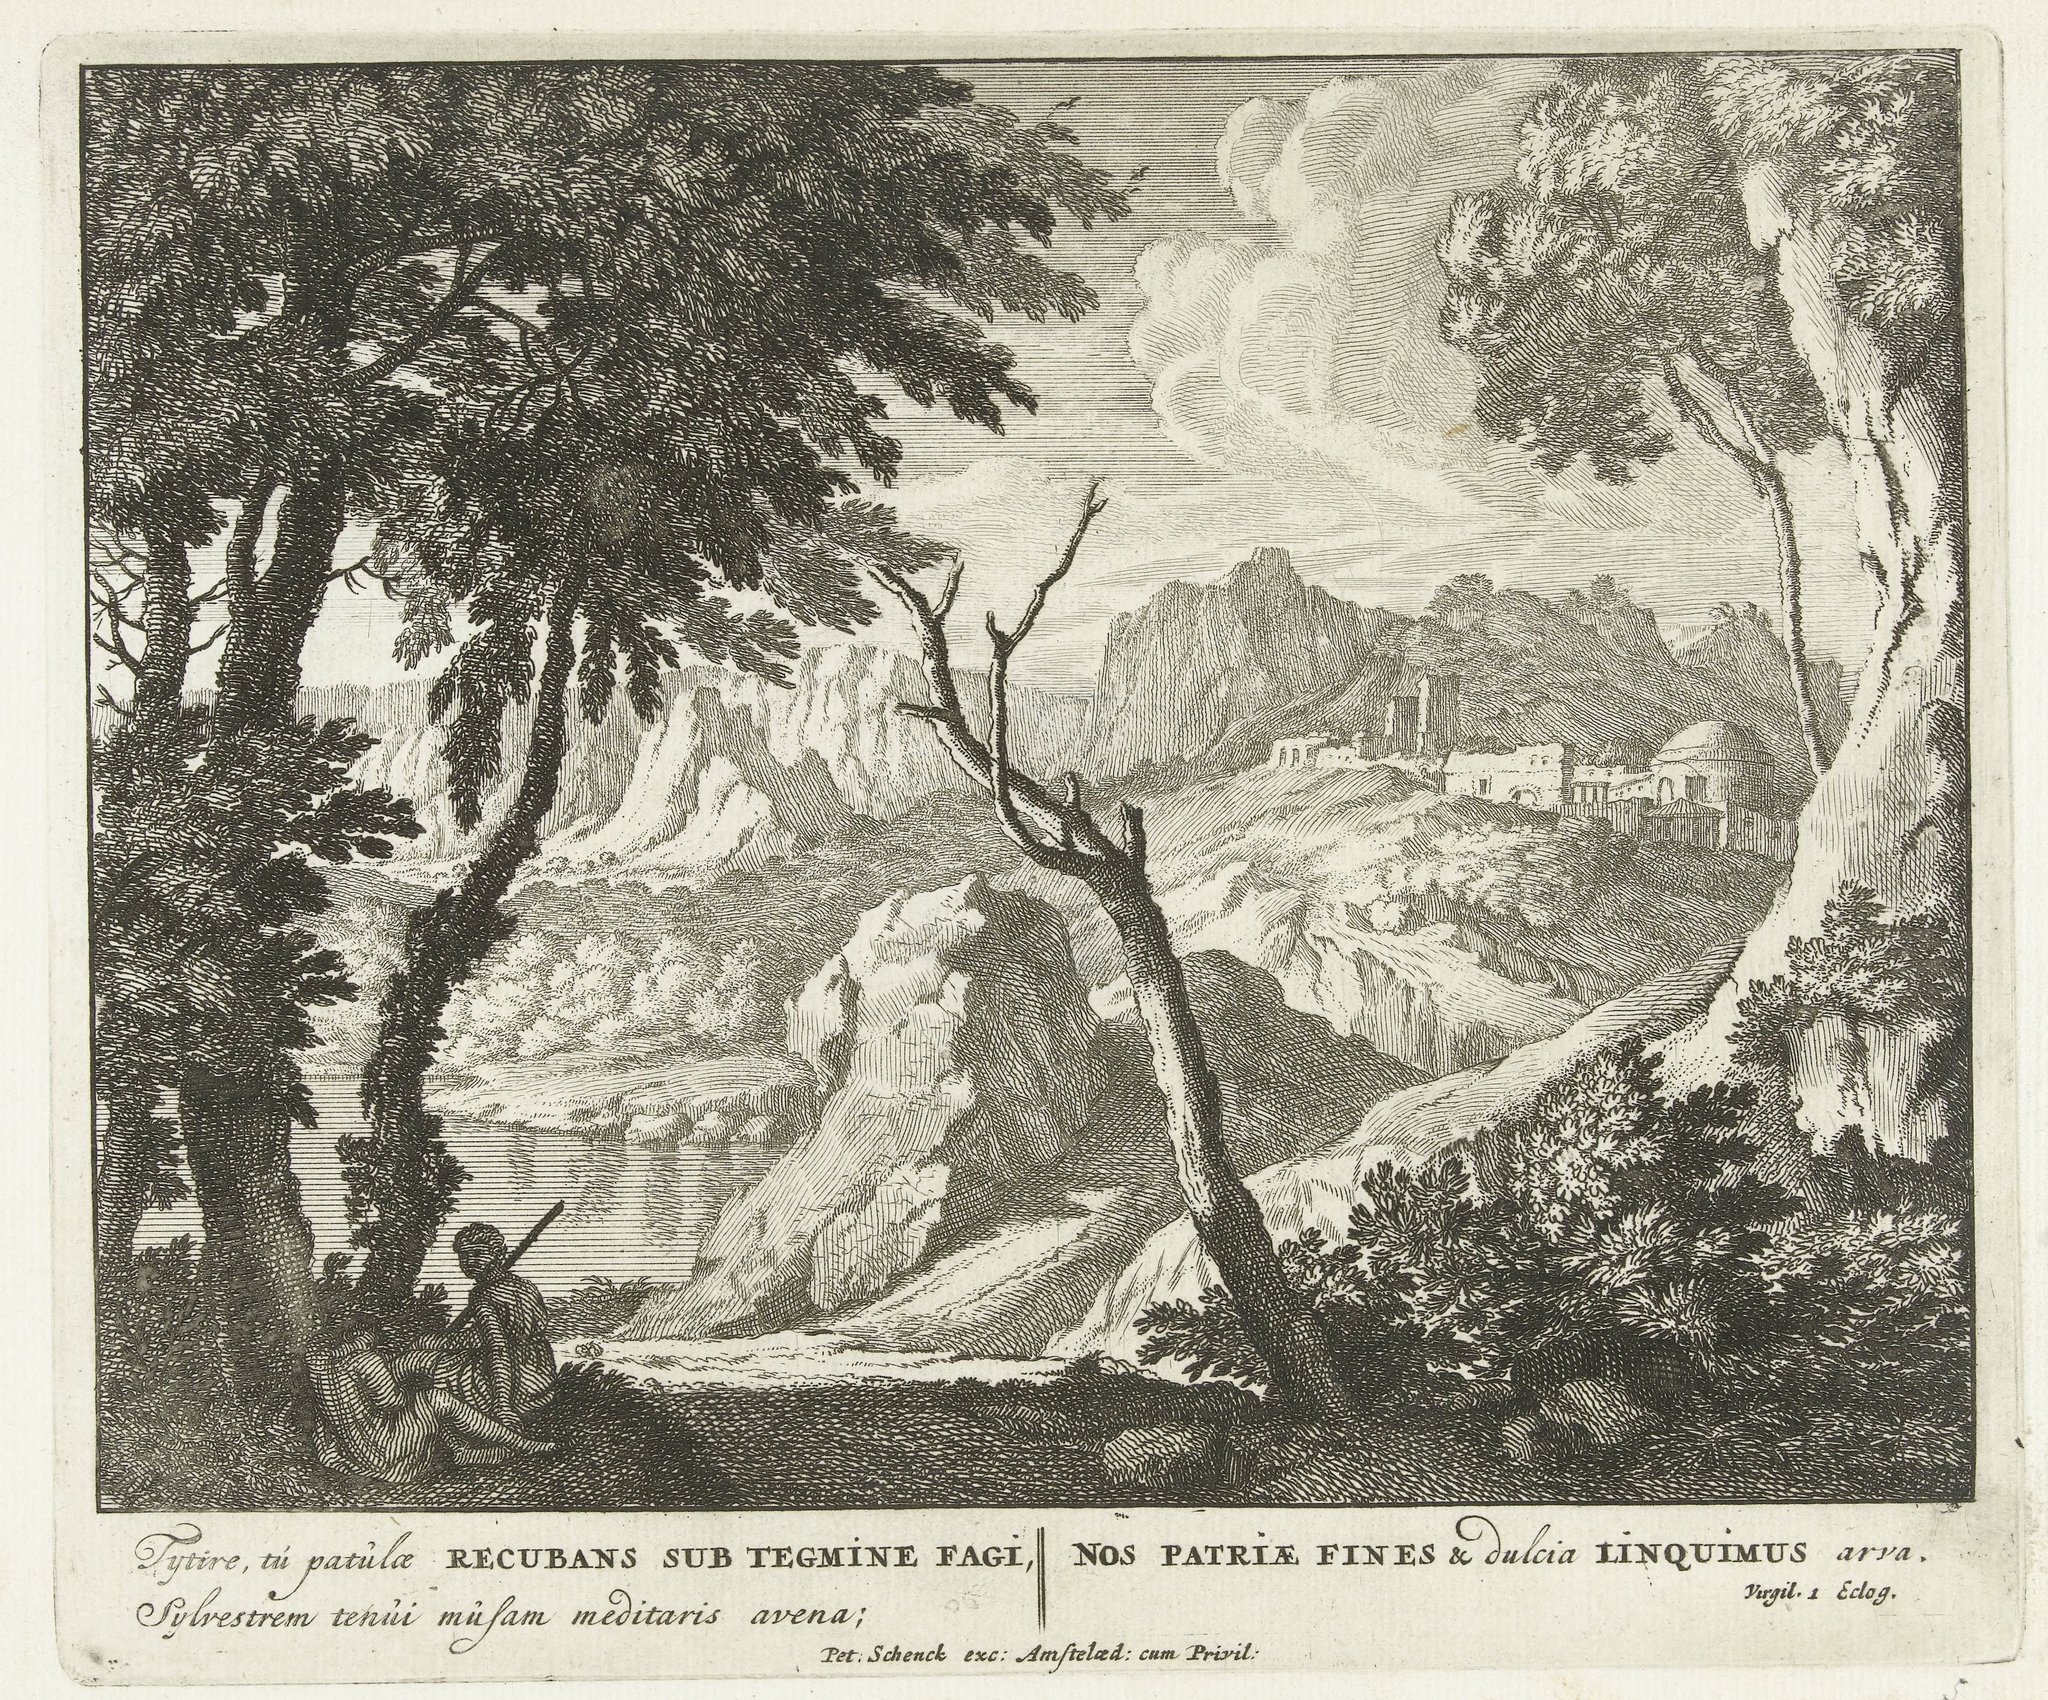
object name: print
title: Scènes uit Vergilius dichtbundel Bucolica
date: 1666-1706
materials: paper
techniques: etching, lithography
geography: amsterdam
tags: pastorals, arcadian scenes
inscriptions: collector's mark: Lugt 2228, collector's mark: Lugt 2760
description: Illustratie voor Ecloga 1 van Virgilius. Een herder en een herderin rusten uit in de schaduw van een boom. Vanuit hun plek hebben ze mooi uitzicht over een dal met een meer en een stad die tussen de rotsen verborgen ligt.